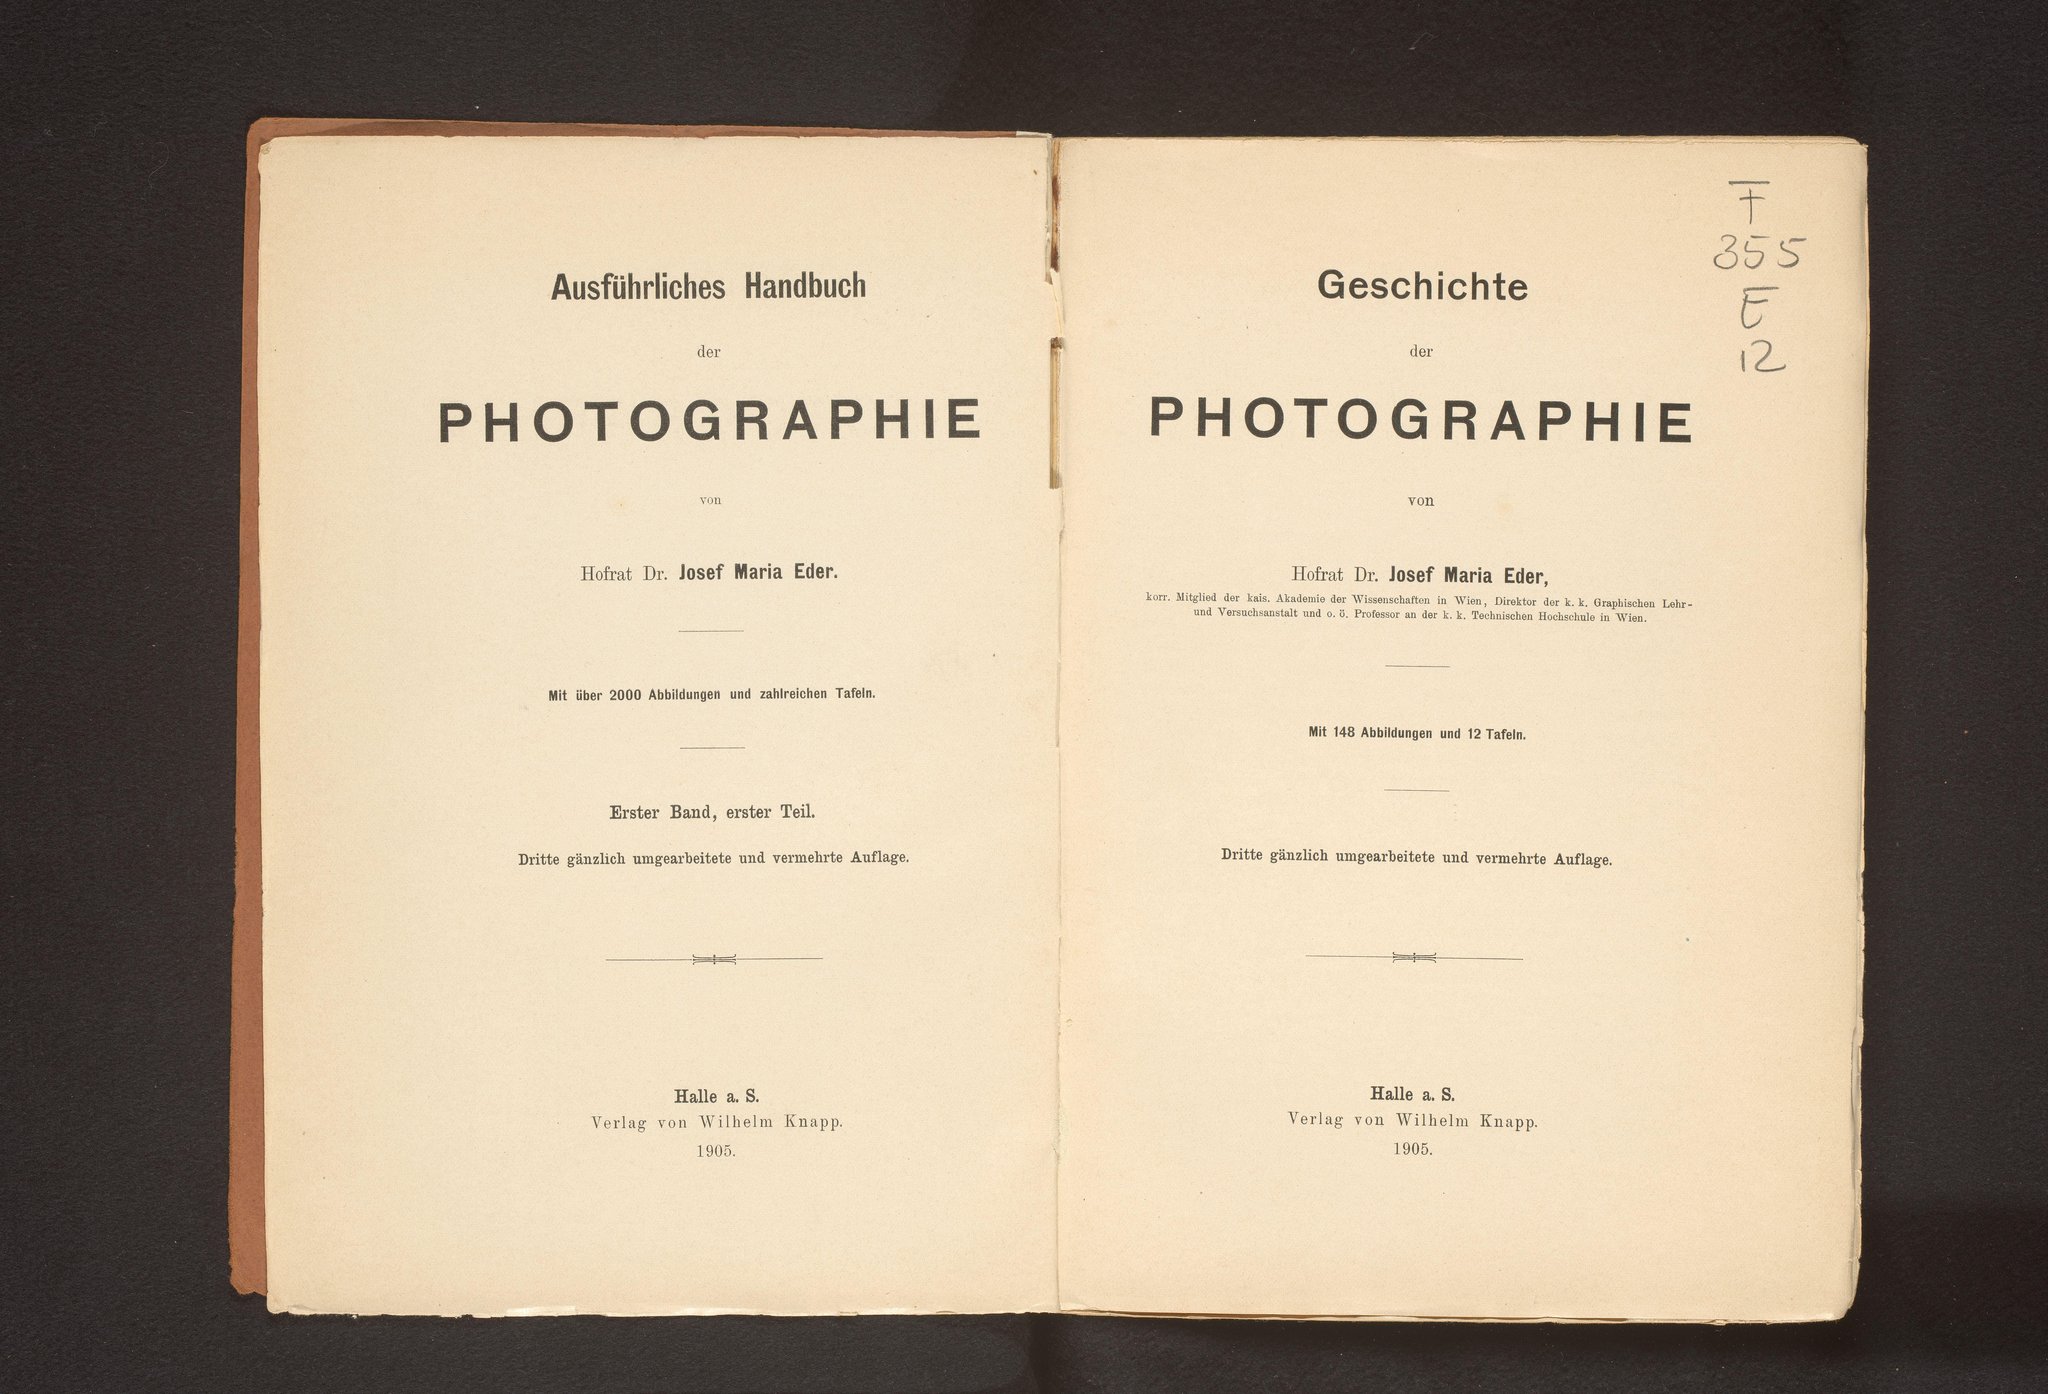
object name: book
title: Geschichte der Photographie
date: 1905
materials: cardboard, paper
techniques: printing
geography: halle an der saale